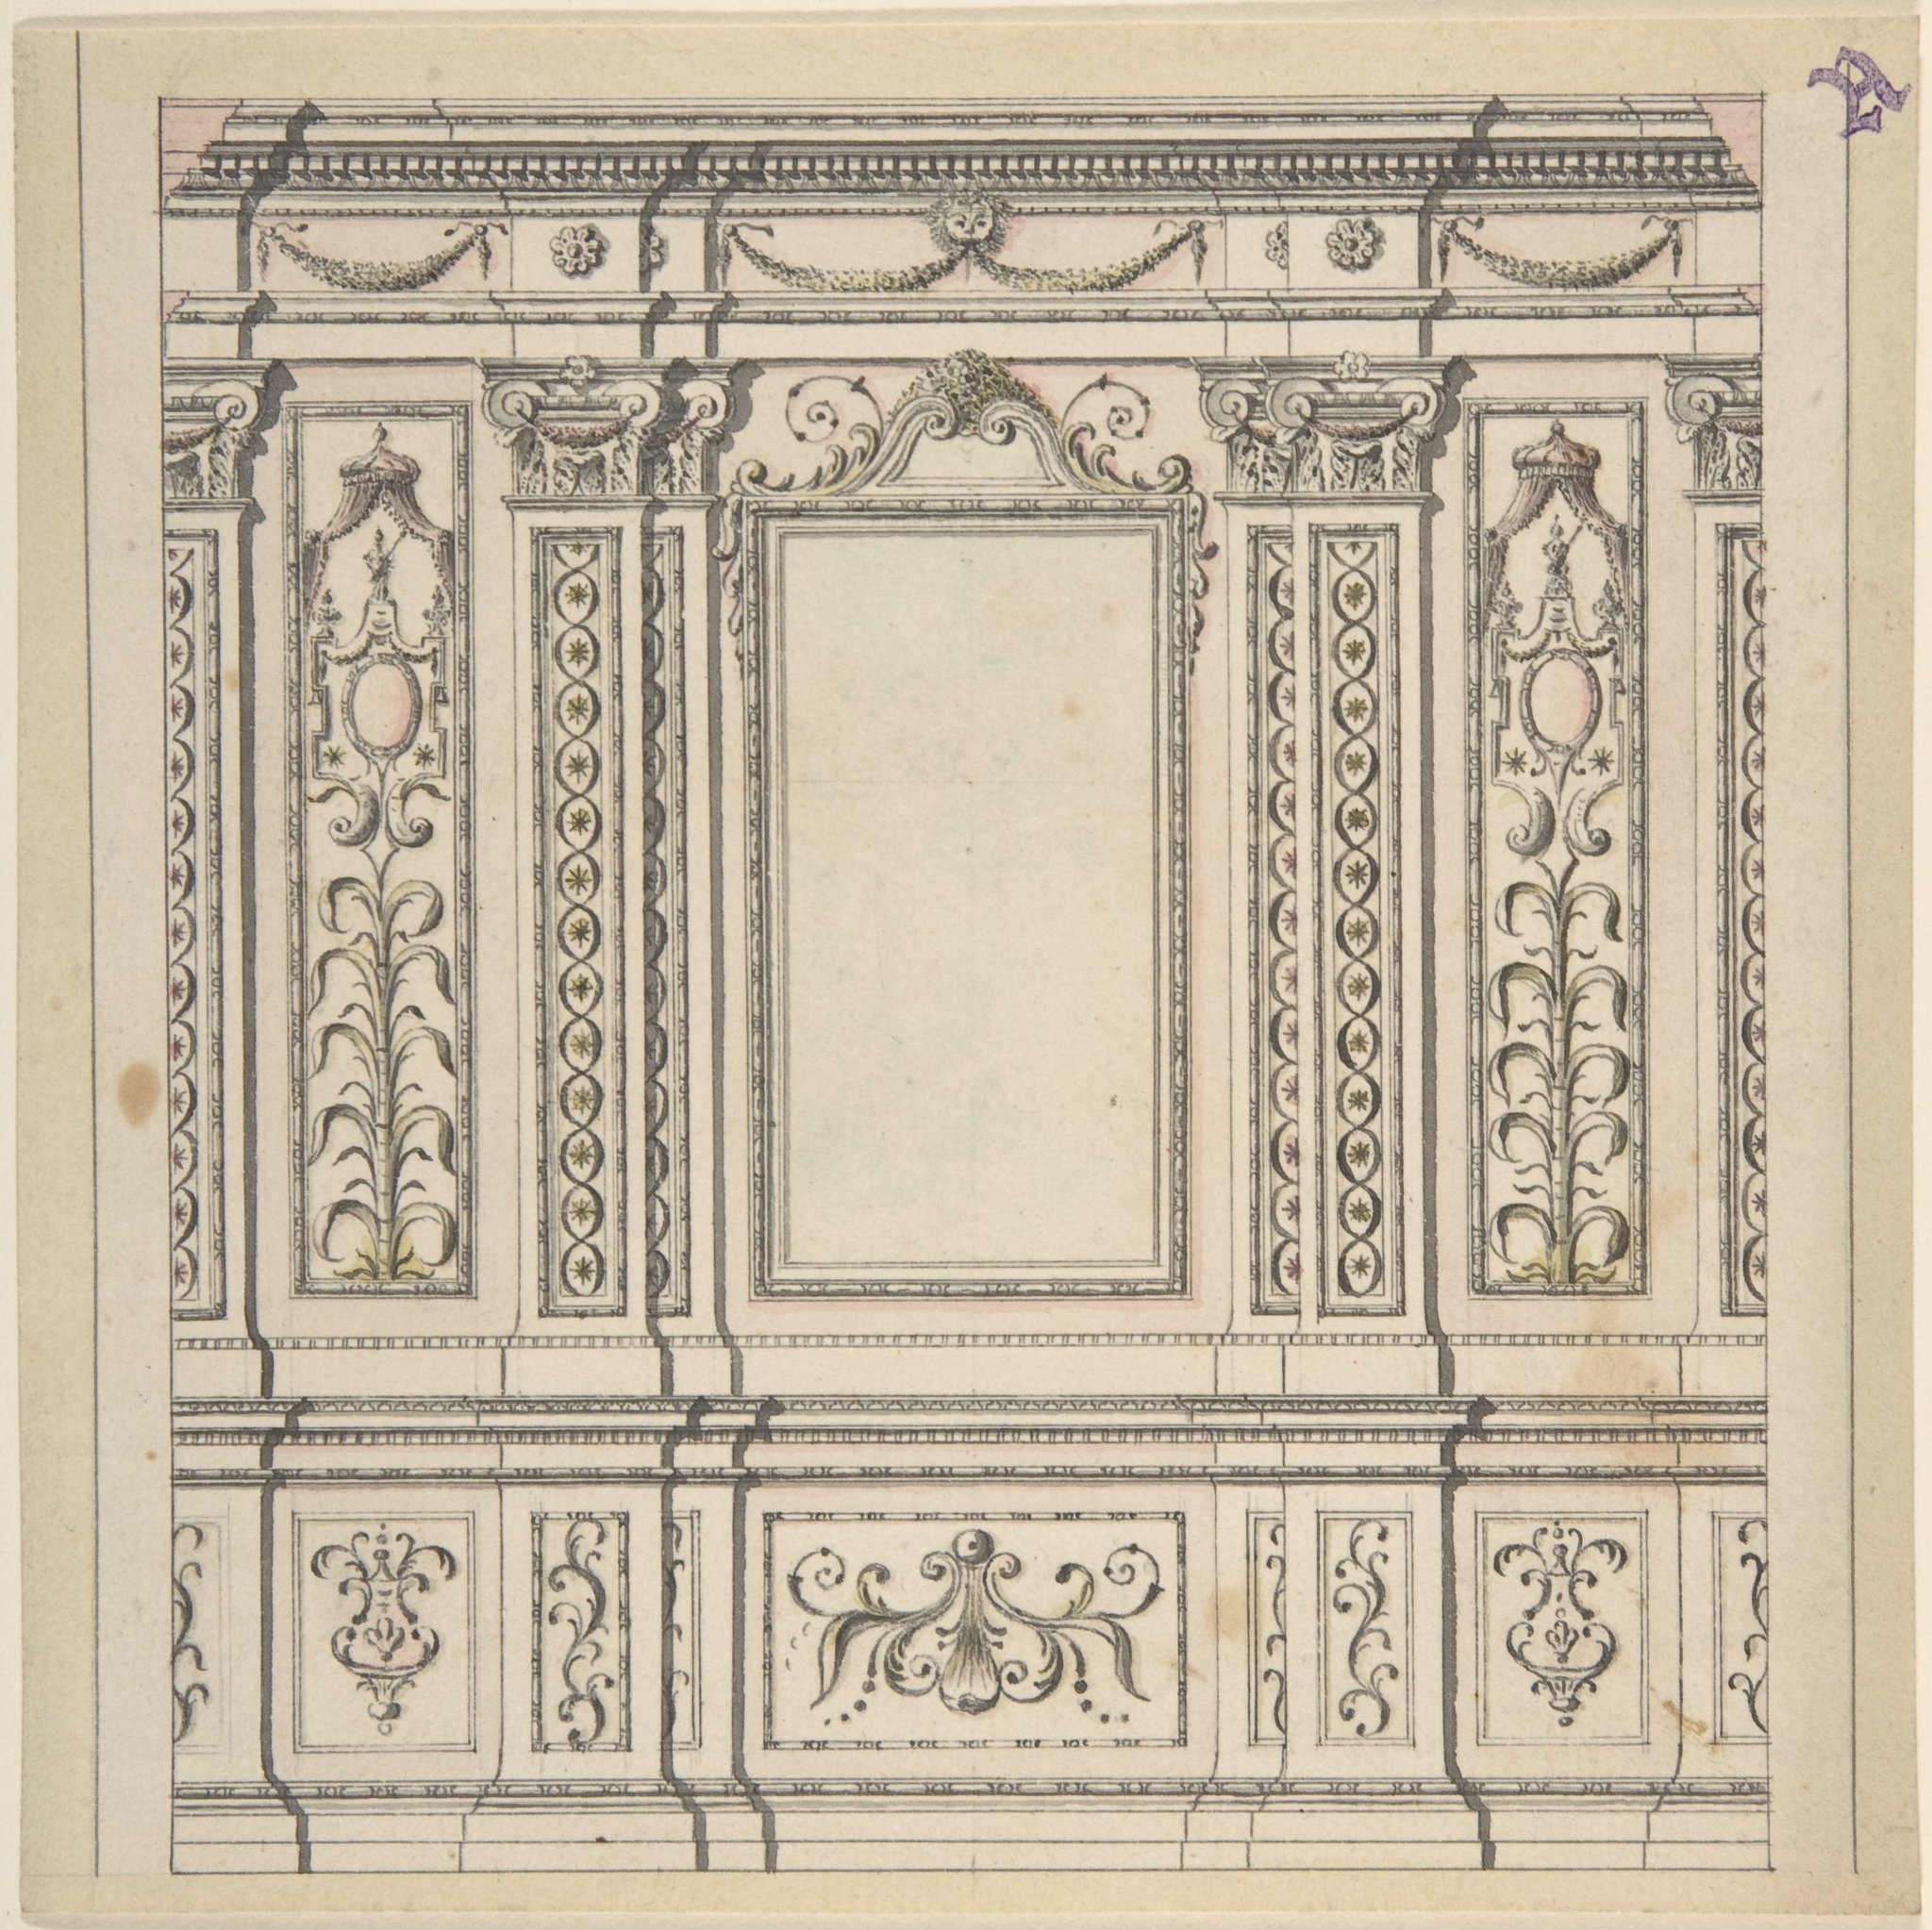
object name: drawing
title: Design for a Wall Decoration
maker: anonymous, italian, north italy, 18th century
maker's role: artist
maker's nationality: italian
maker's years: 1700-1800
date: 1780-1800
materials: ink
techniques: pen, wash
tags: architecture